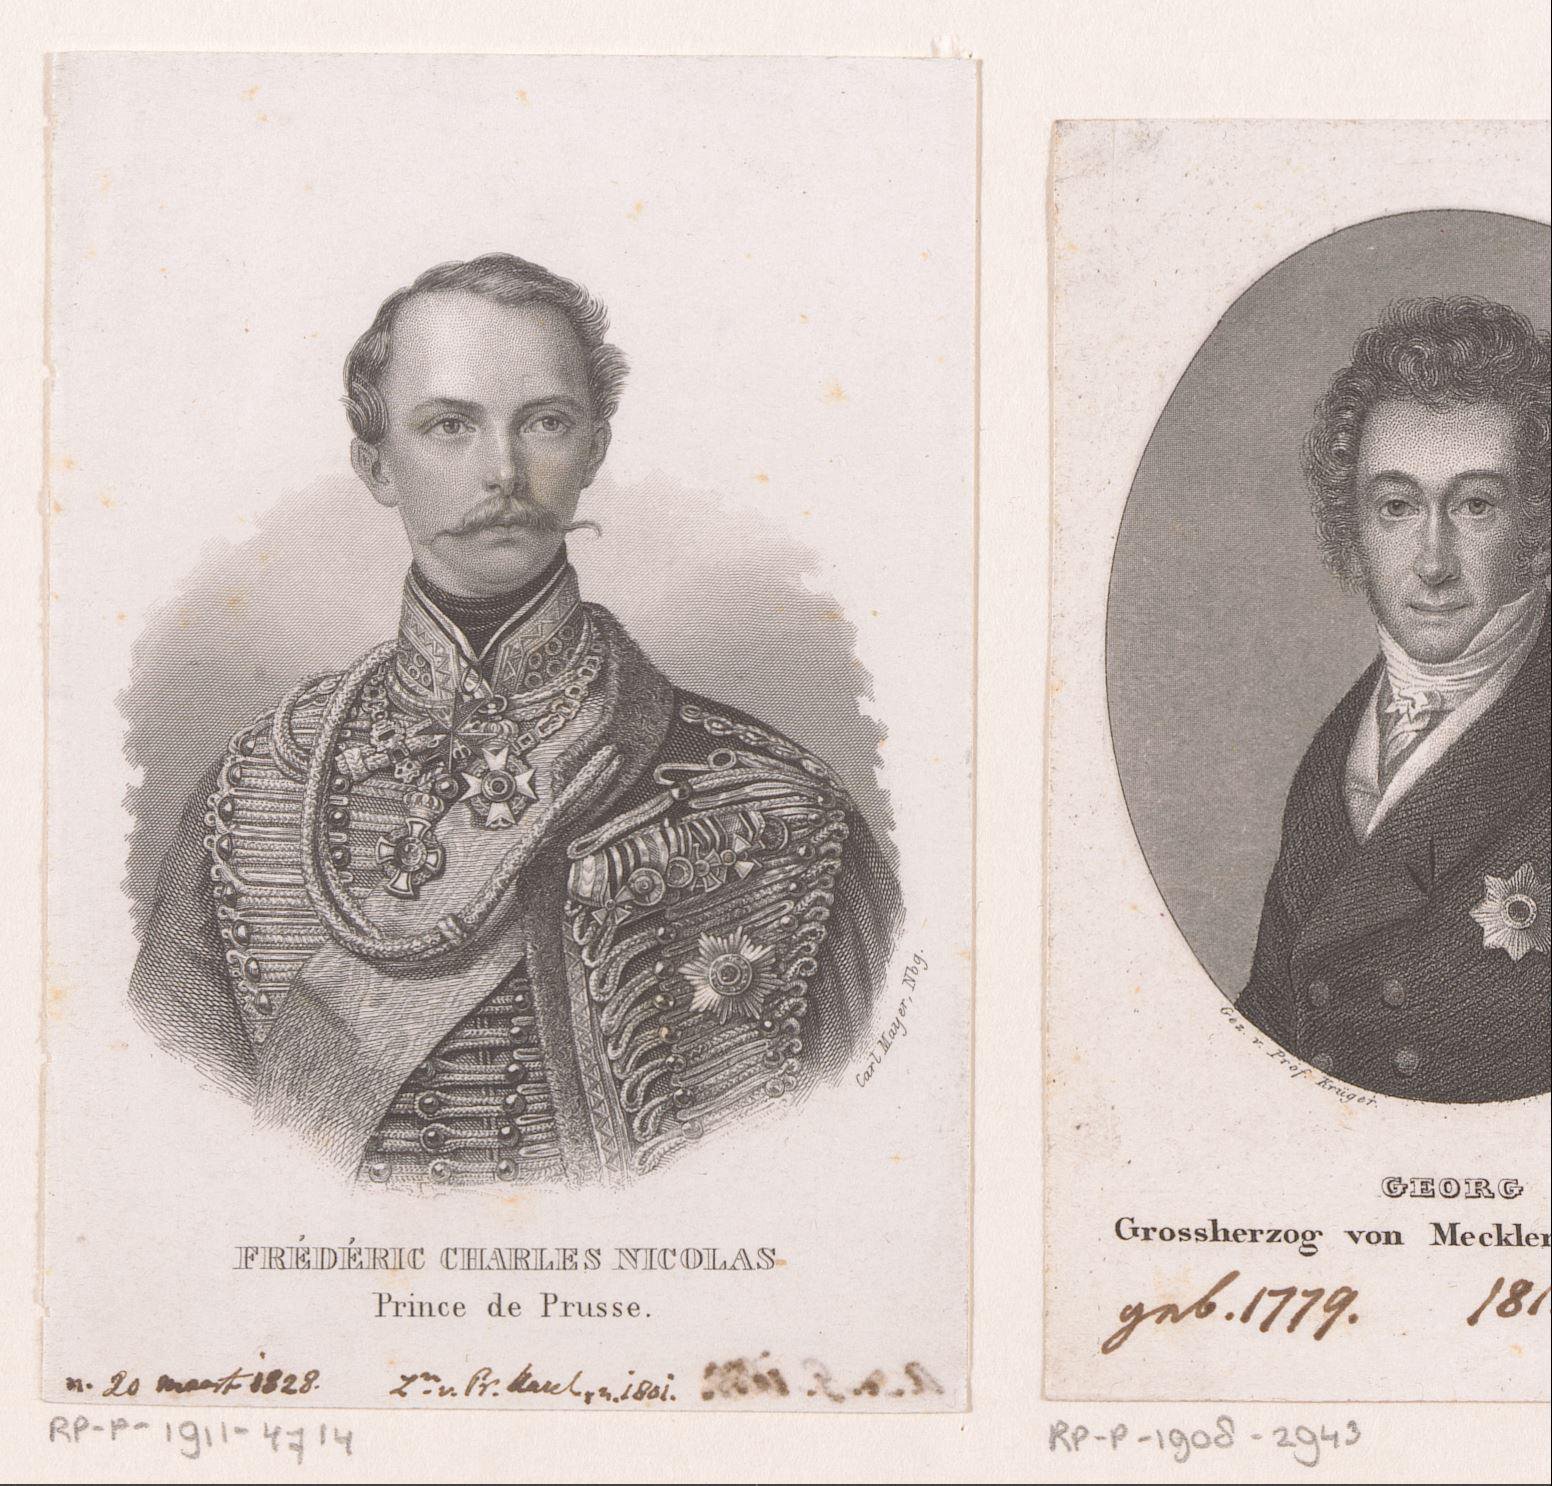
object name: print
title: Portret van Frederik Karel Nicolaas van Pruisen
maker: carl mayer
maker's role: print maker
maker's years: 1798-1868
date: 1855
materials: paper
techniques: engraving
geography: nuremberg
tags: berlin, historical persons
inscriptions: collector's mark: Lugt 2228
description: Vermoedelijk afkomstig uit: Almanach de Gotha, 1855.